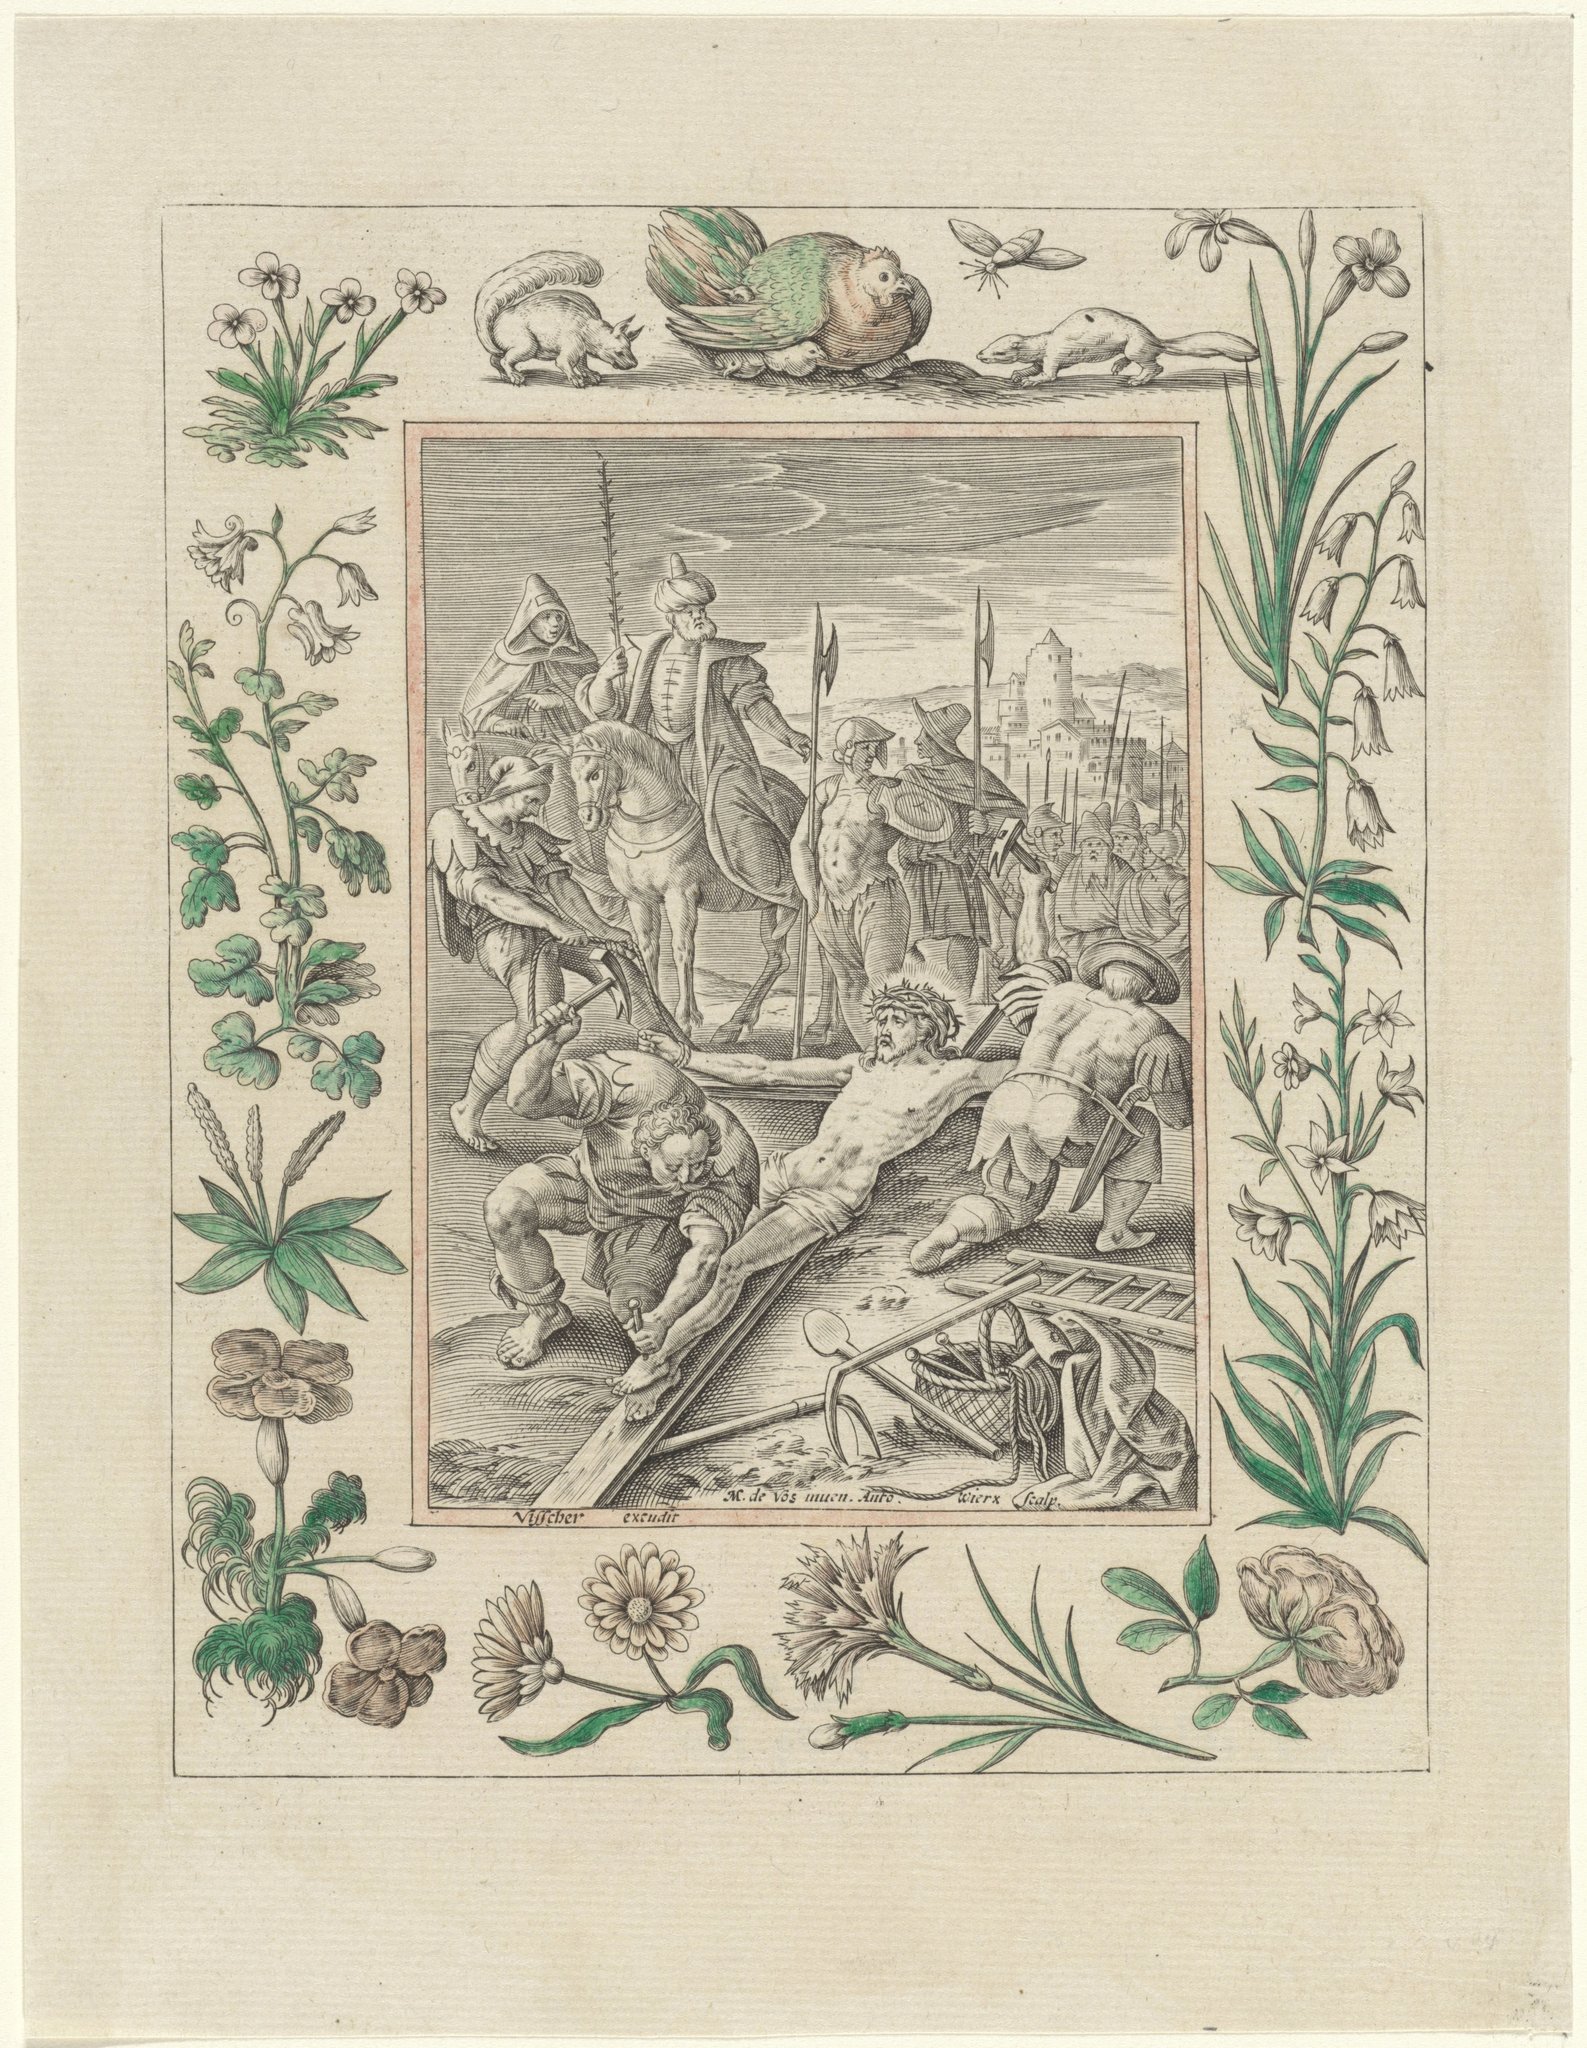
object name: print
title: Christus wordt aan het kruis genageld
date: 1582-1586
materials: paper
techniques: engraving, hand coloring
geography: antwerp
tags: flowers, animals, the erection of the cross: christ is nailed to the cross which lies on the ground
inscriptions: collector's mark: Lugt 2228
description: Christus wordt door twee mannen aan het kruis genageld. Soldaten te paard kijken toe. De voorstelling is gevat in een ornamentele omlijsting die is gedecoreerd met dieren en bloemen.